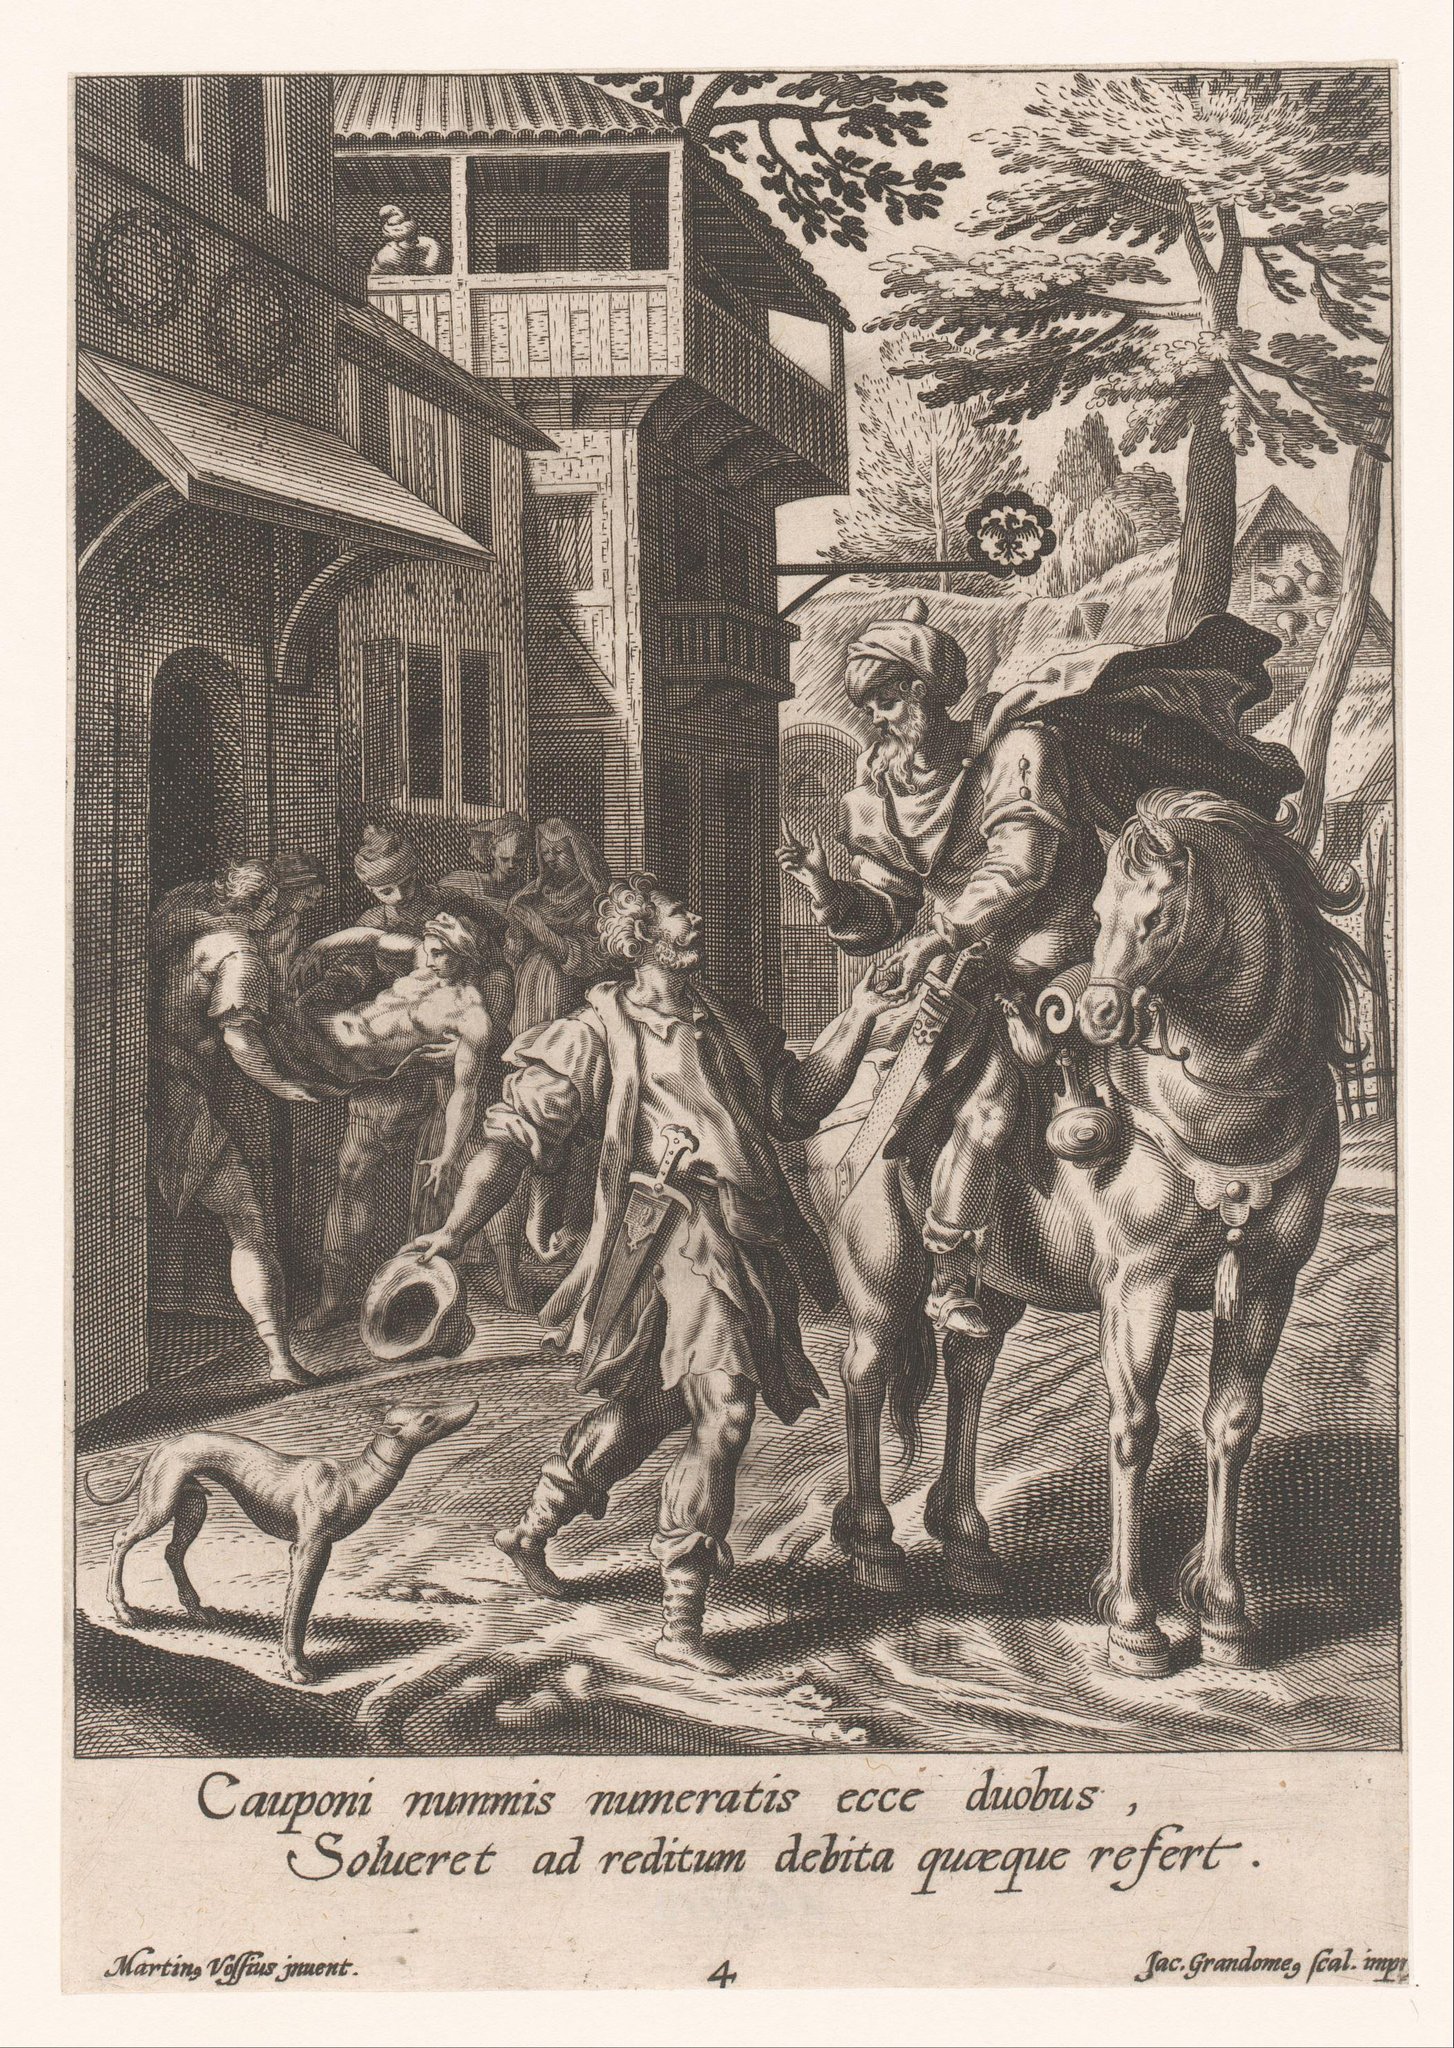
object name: print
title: Barmhartige Samaritaan betaalt de herbergier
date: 1588-1622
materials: paper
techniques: engraving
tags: the samaritan pays the innkeeper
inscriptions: collector's mark: Lugt 2228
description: Maakt deel uit van een vierdelige serie met de gelijkenis van de Barmhartige Samaritaan naar Maerten de Vos.